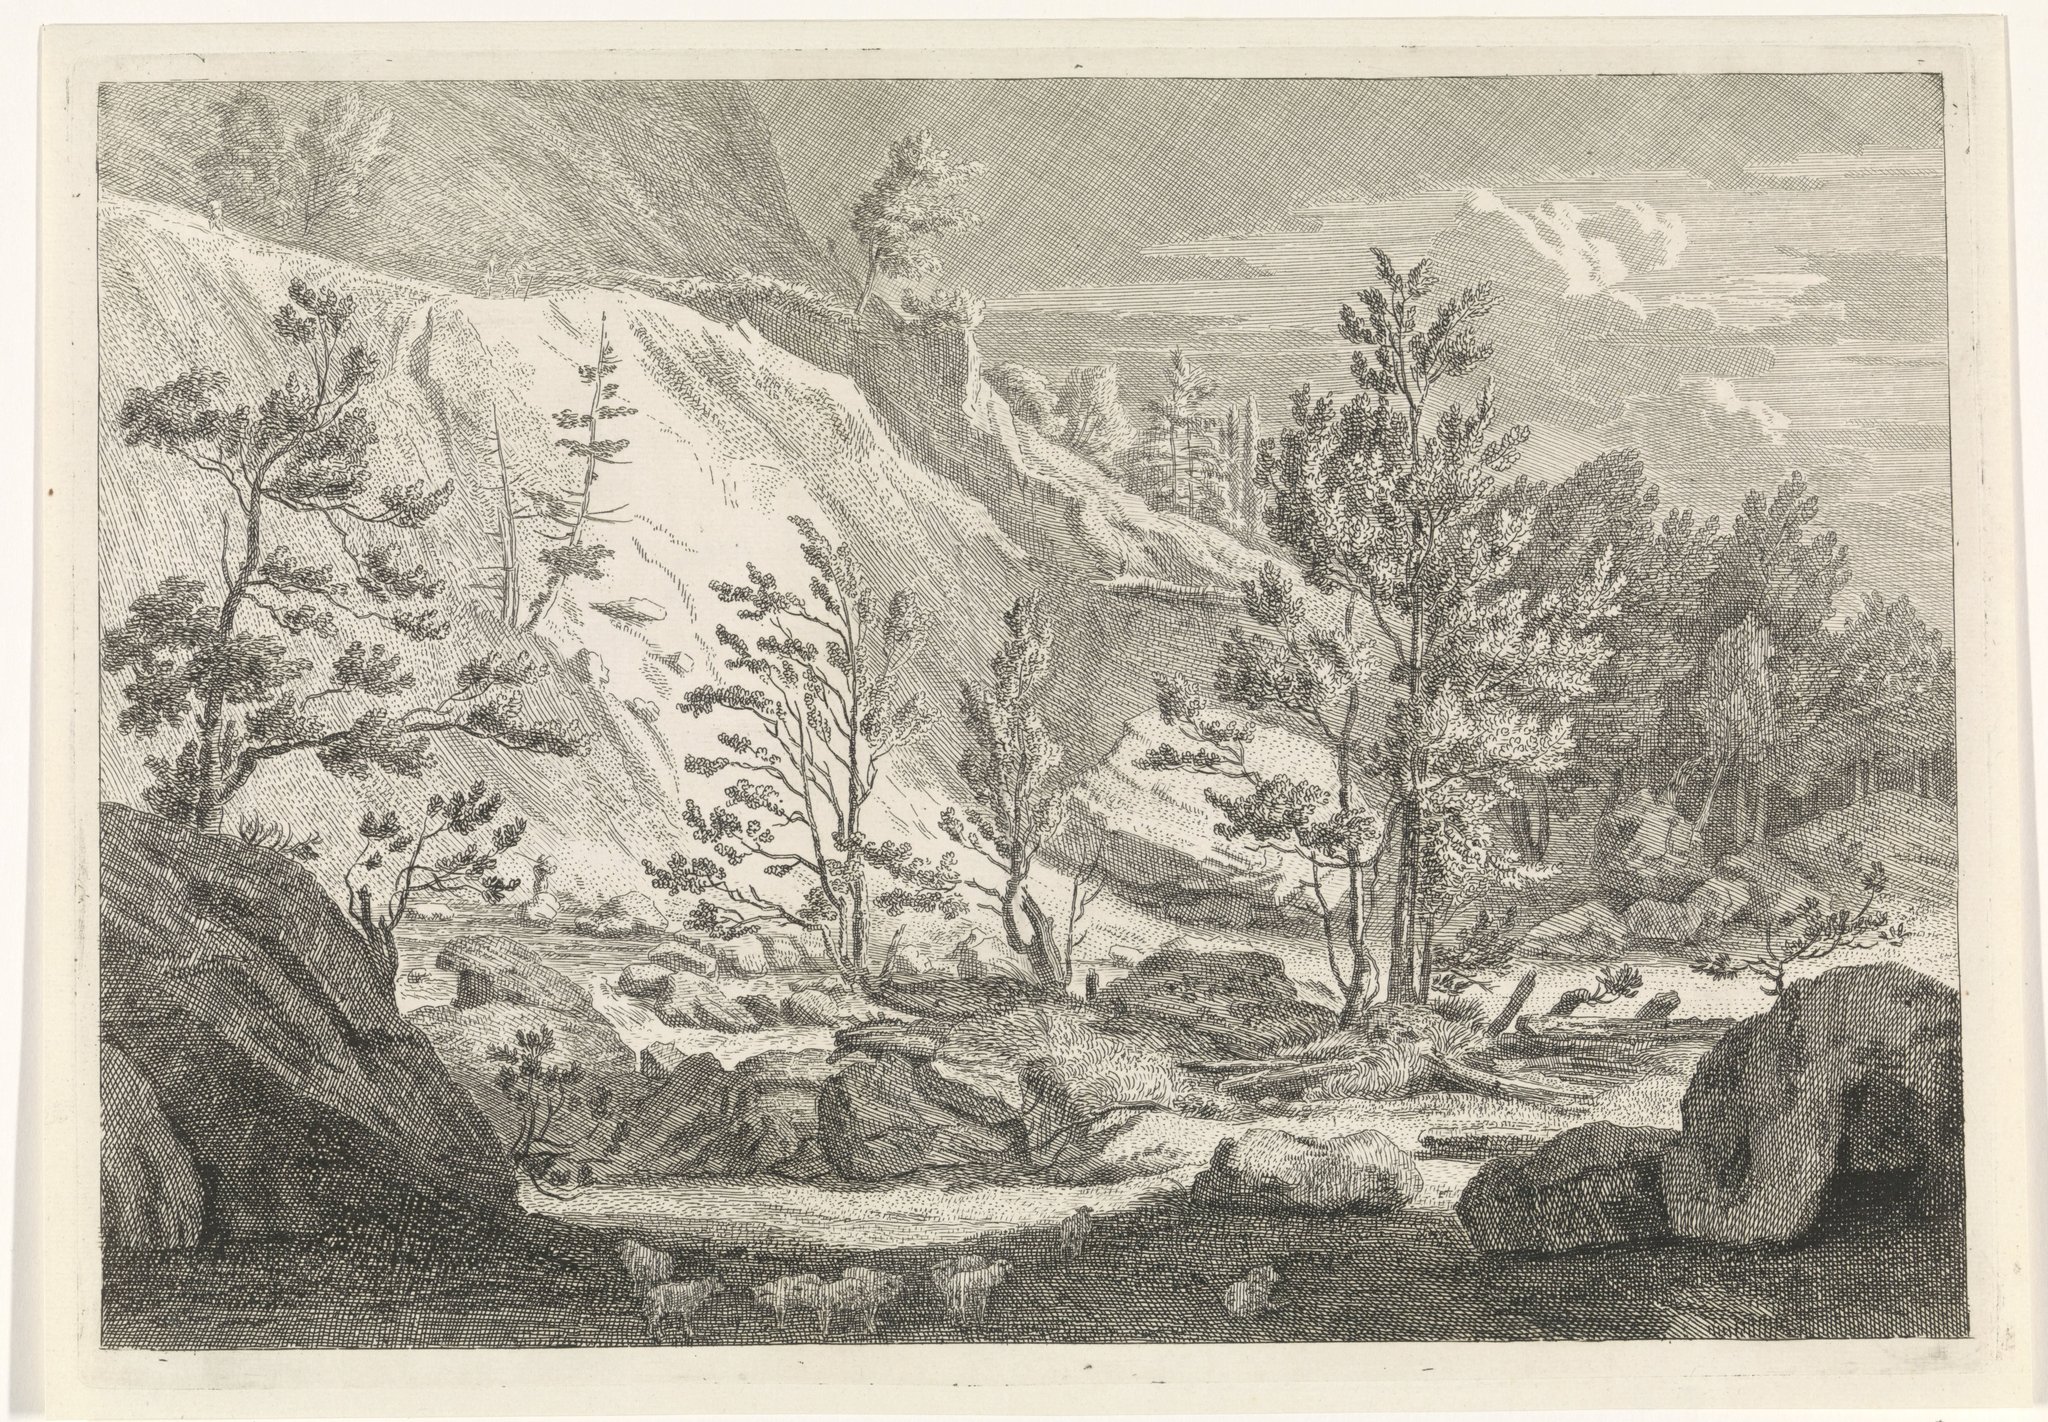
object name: print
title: Ravijn met een kudde schapen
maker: johannes glauber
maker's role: draughtsman, painter, print maker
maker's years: 1646-1726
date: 1656-1726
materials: paper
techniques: etching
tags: sheep, rock-formations, ravine, chasm, abyss, canyon (+ landscape with figures, staffage)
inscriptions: collector's mark: Lugt 2228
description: Gezicht op een ravijn. Op de voorgrond een kudde schapen. De prent maakt deel uit van een serie met berglandschappen in het Chartreuzer-gebergte.